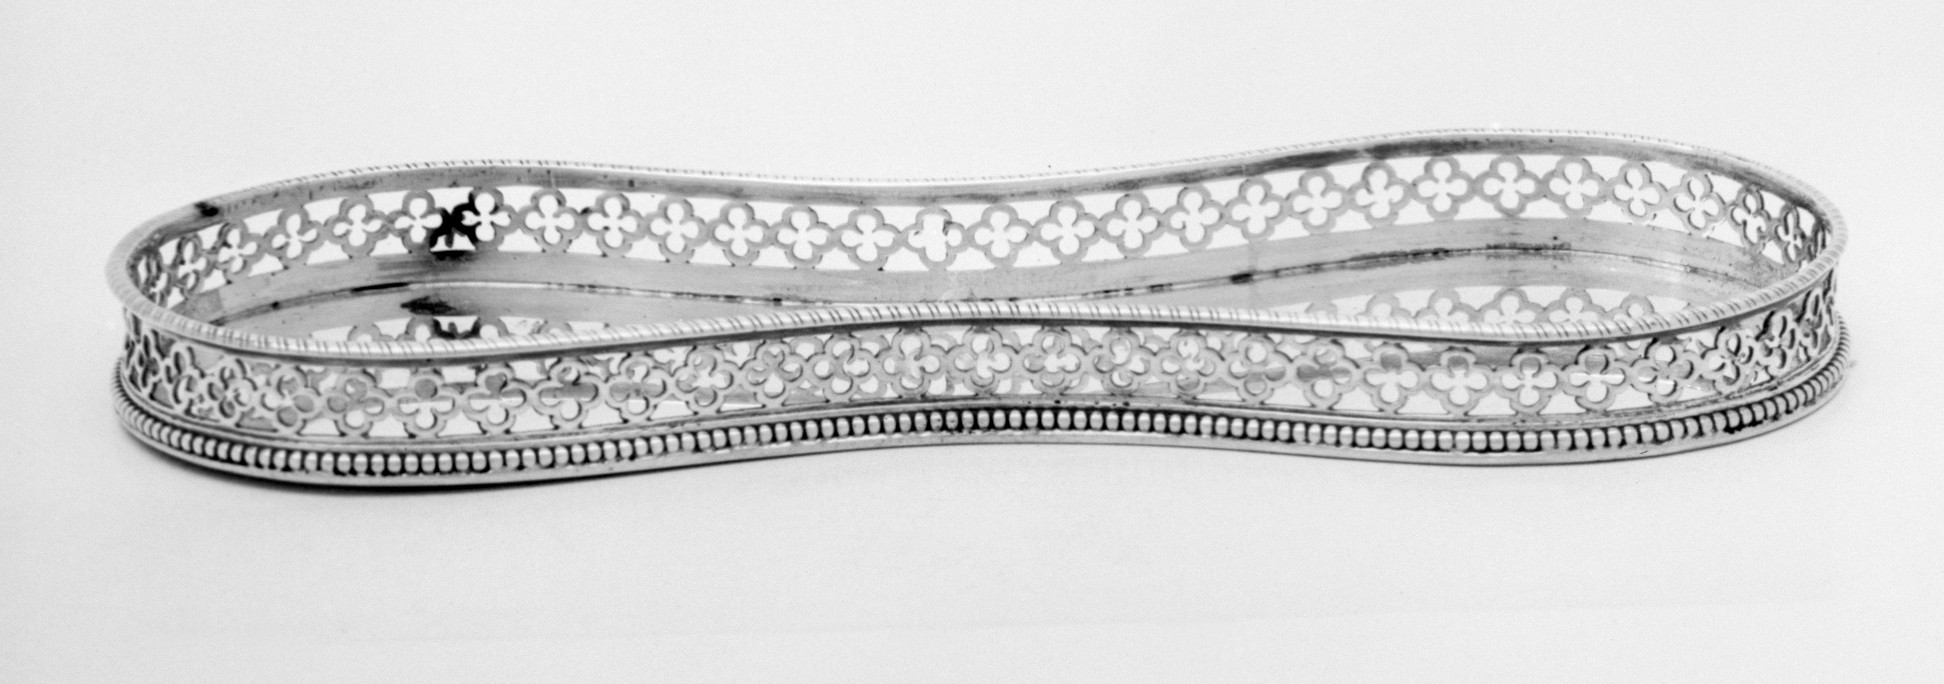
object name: snuffer tray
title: Snuffers tray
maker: charles aldrich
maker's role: maker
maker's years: 1775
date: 1777-1778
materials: silver